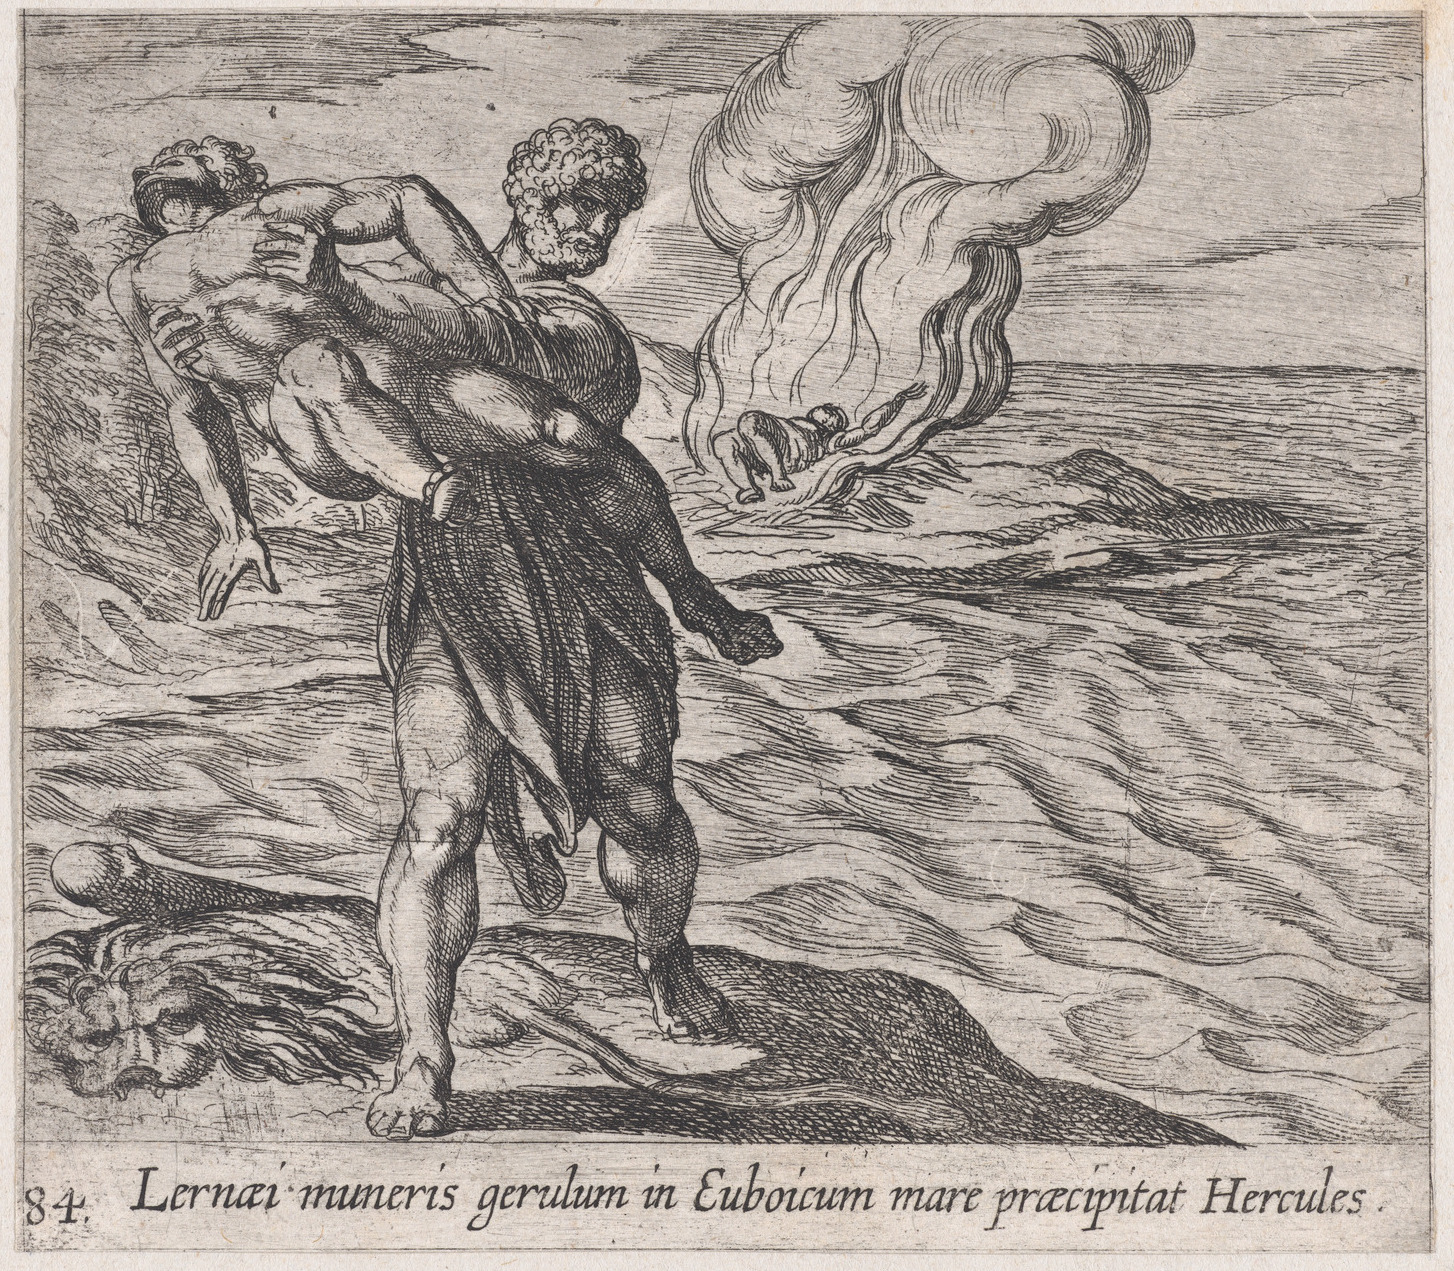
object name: print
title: Plate 84: Hercules Throwing Lichas into the Sea (Lernaei muneris gerulum in Euboicum mare praecipitat Hercules), from Ovid's 'Metamorphoses'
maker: antonio tempesta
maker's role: artist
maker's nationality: italian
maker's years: 1555-1630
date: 1606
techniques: etching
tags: men,hercules,lions